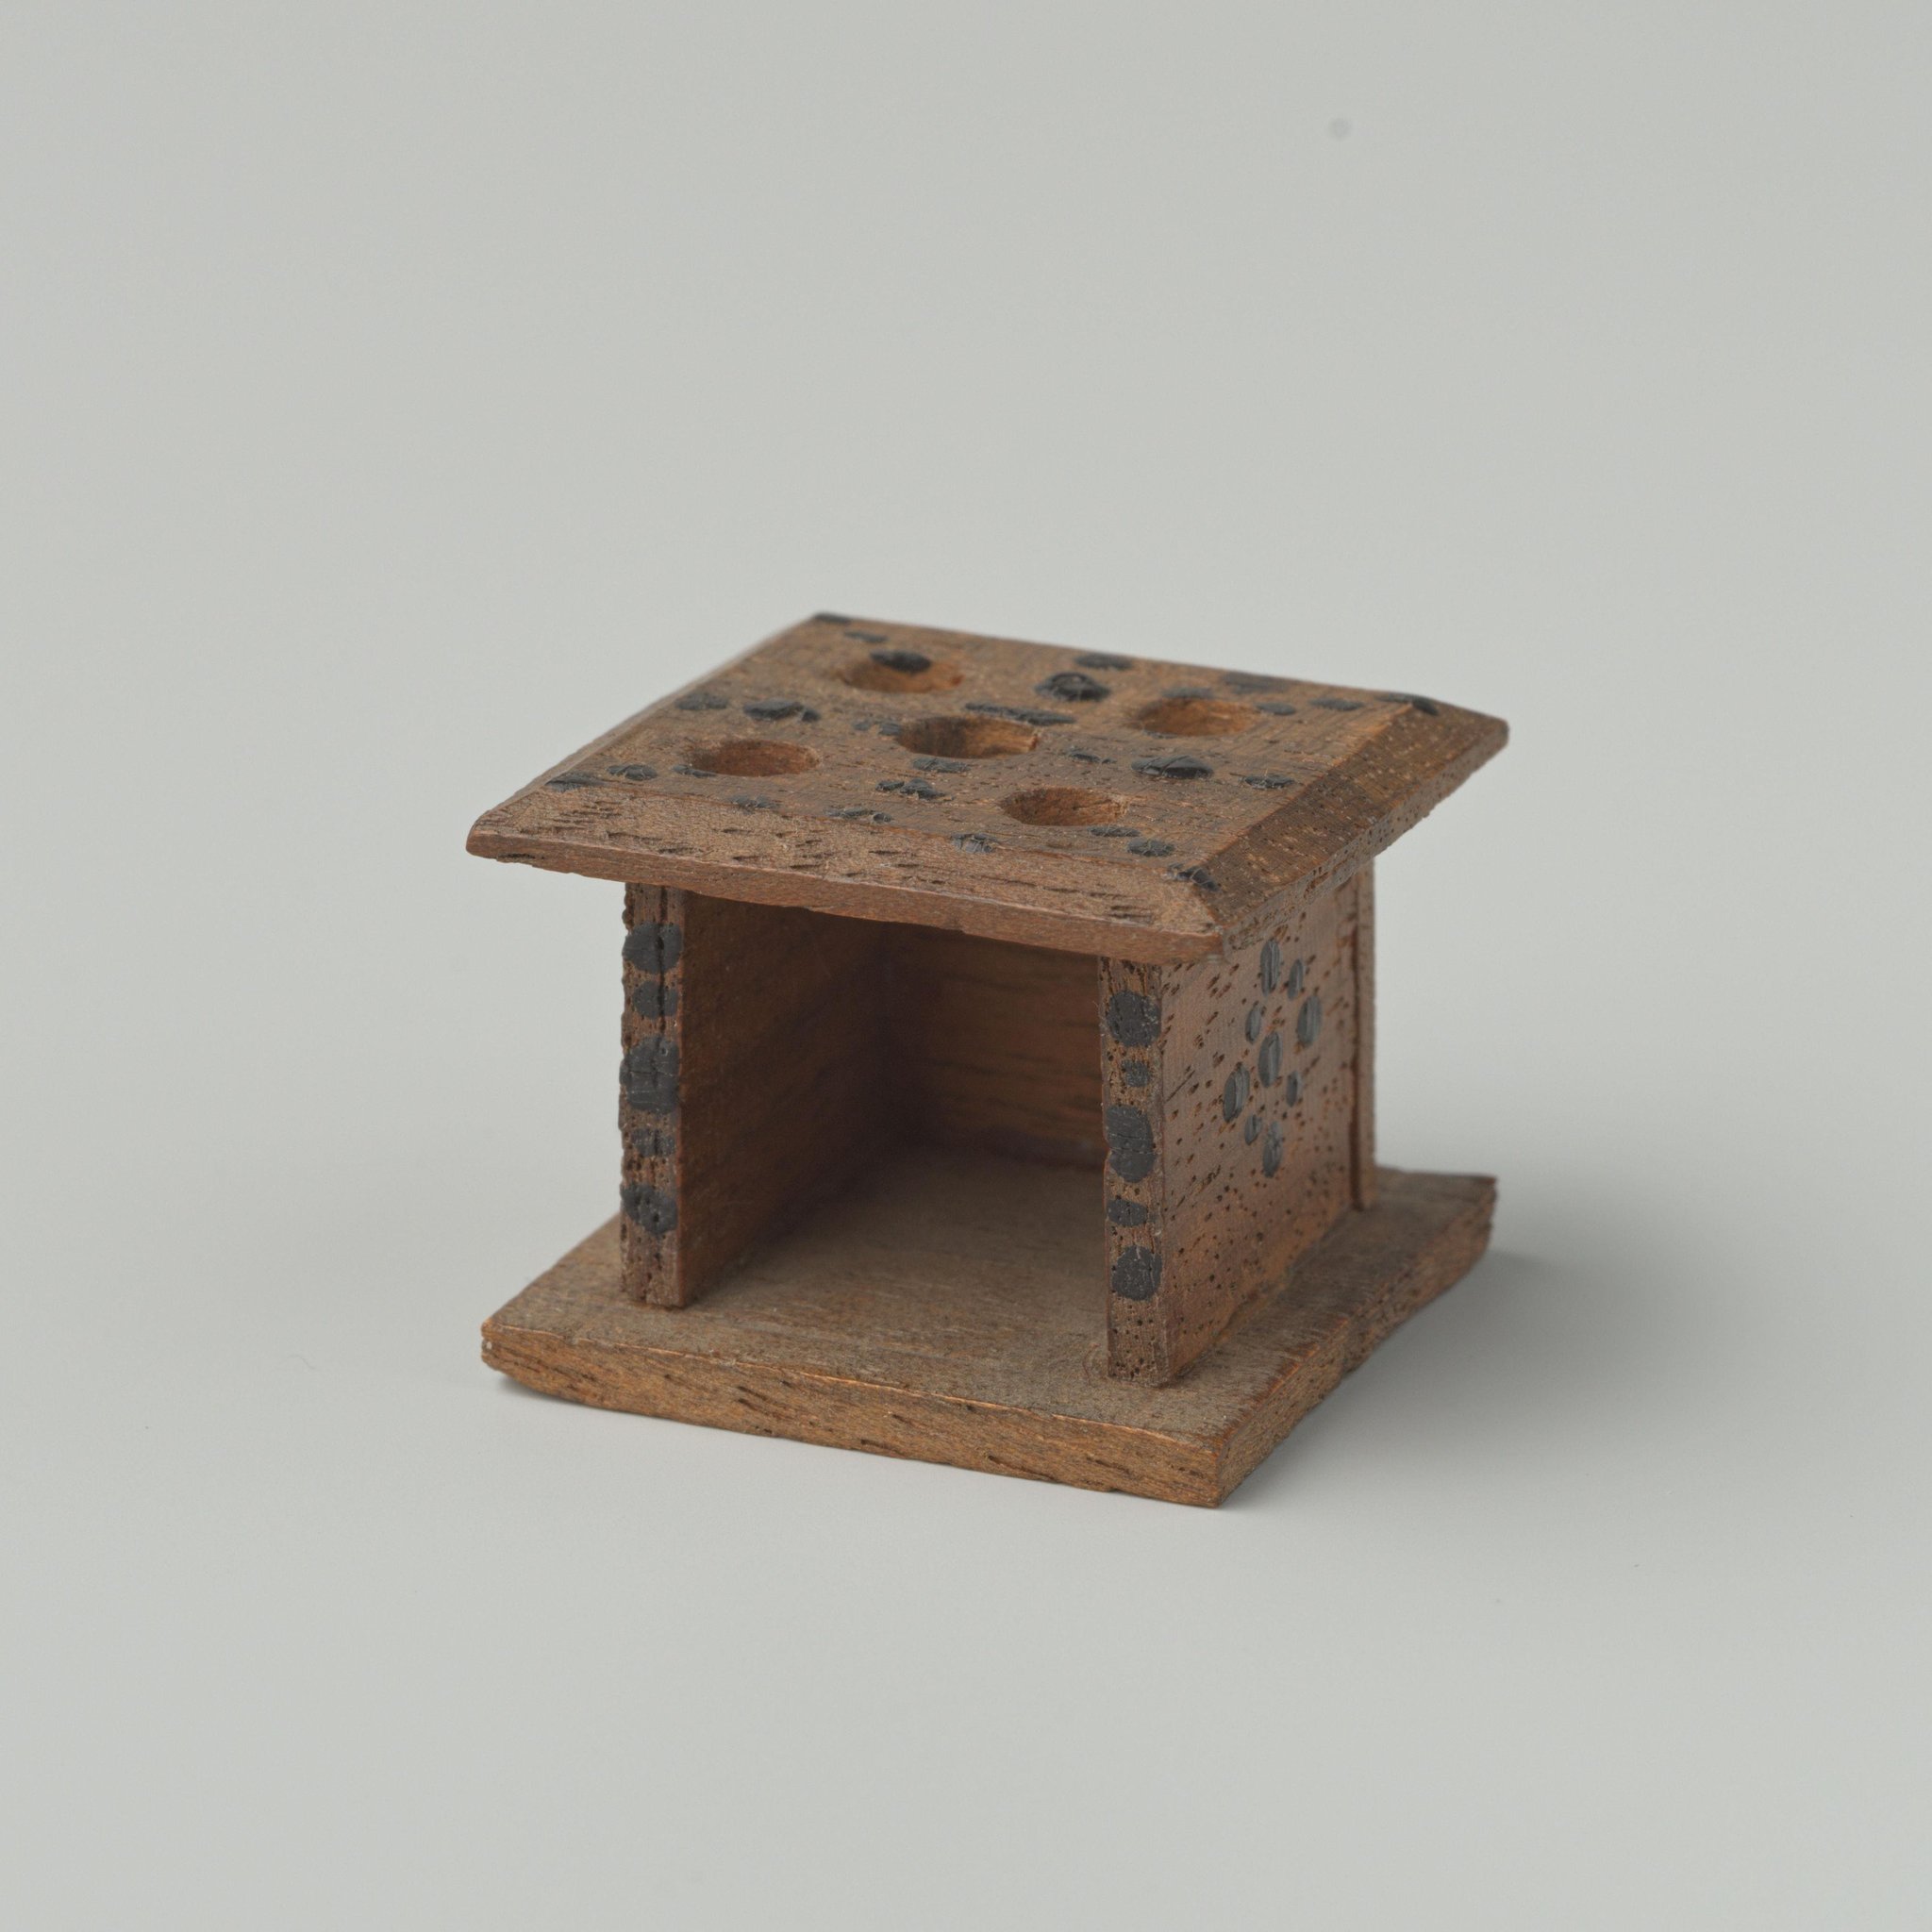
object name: miniature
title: Stoof van notenhout, versierd met zwarte stippen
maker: Anonymous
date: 1676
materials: wood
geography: amsterdam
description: Stoof van notenhout, vierkant, versierd met zwarte stippen. In de voetenplank zijn vijf gaten aangebracht.